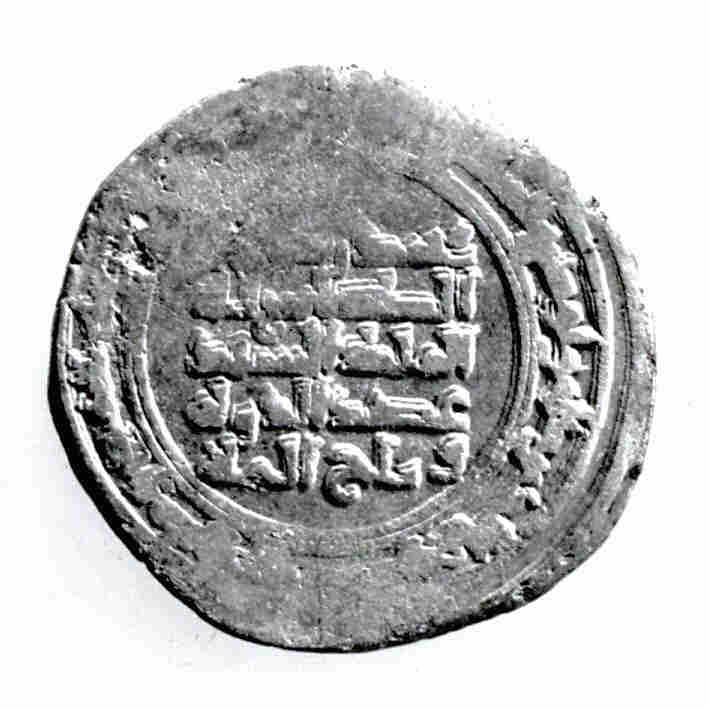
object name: coin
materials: silver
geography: iran